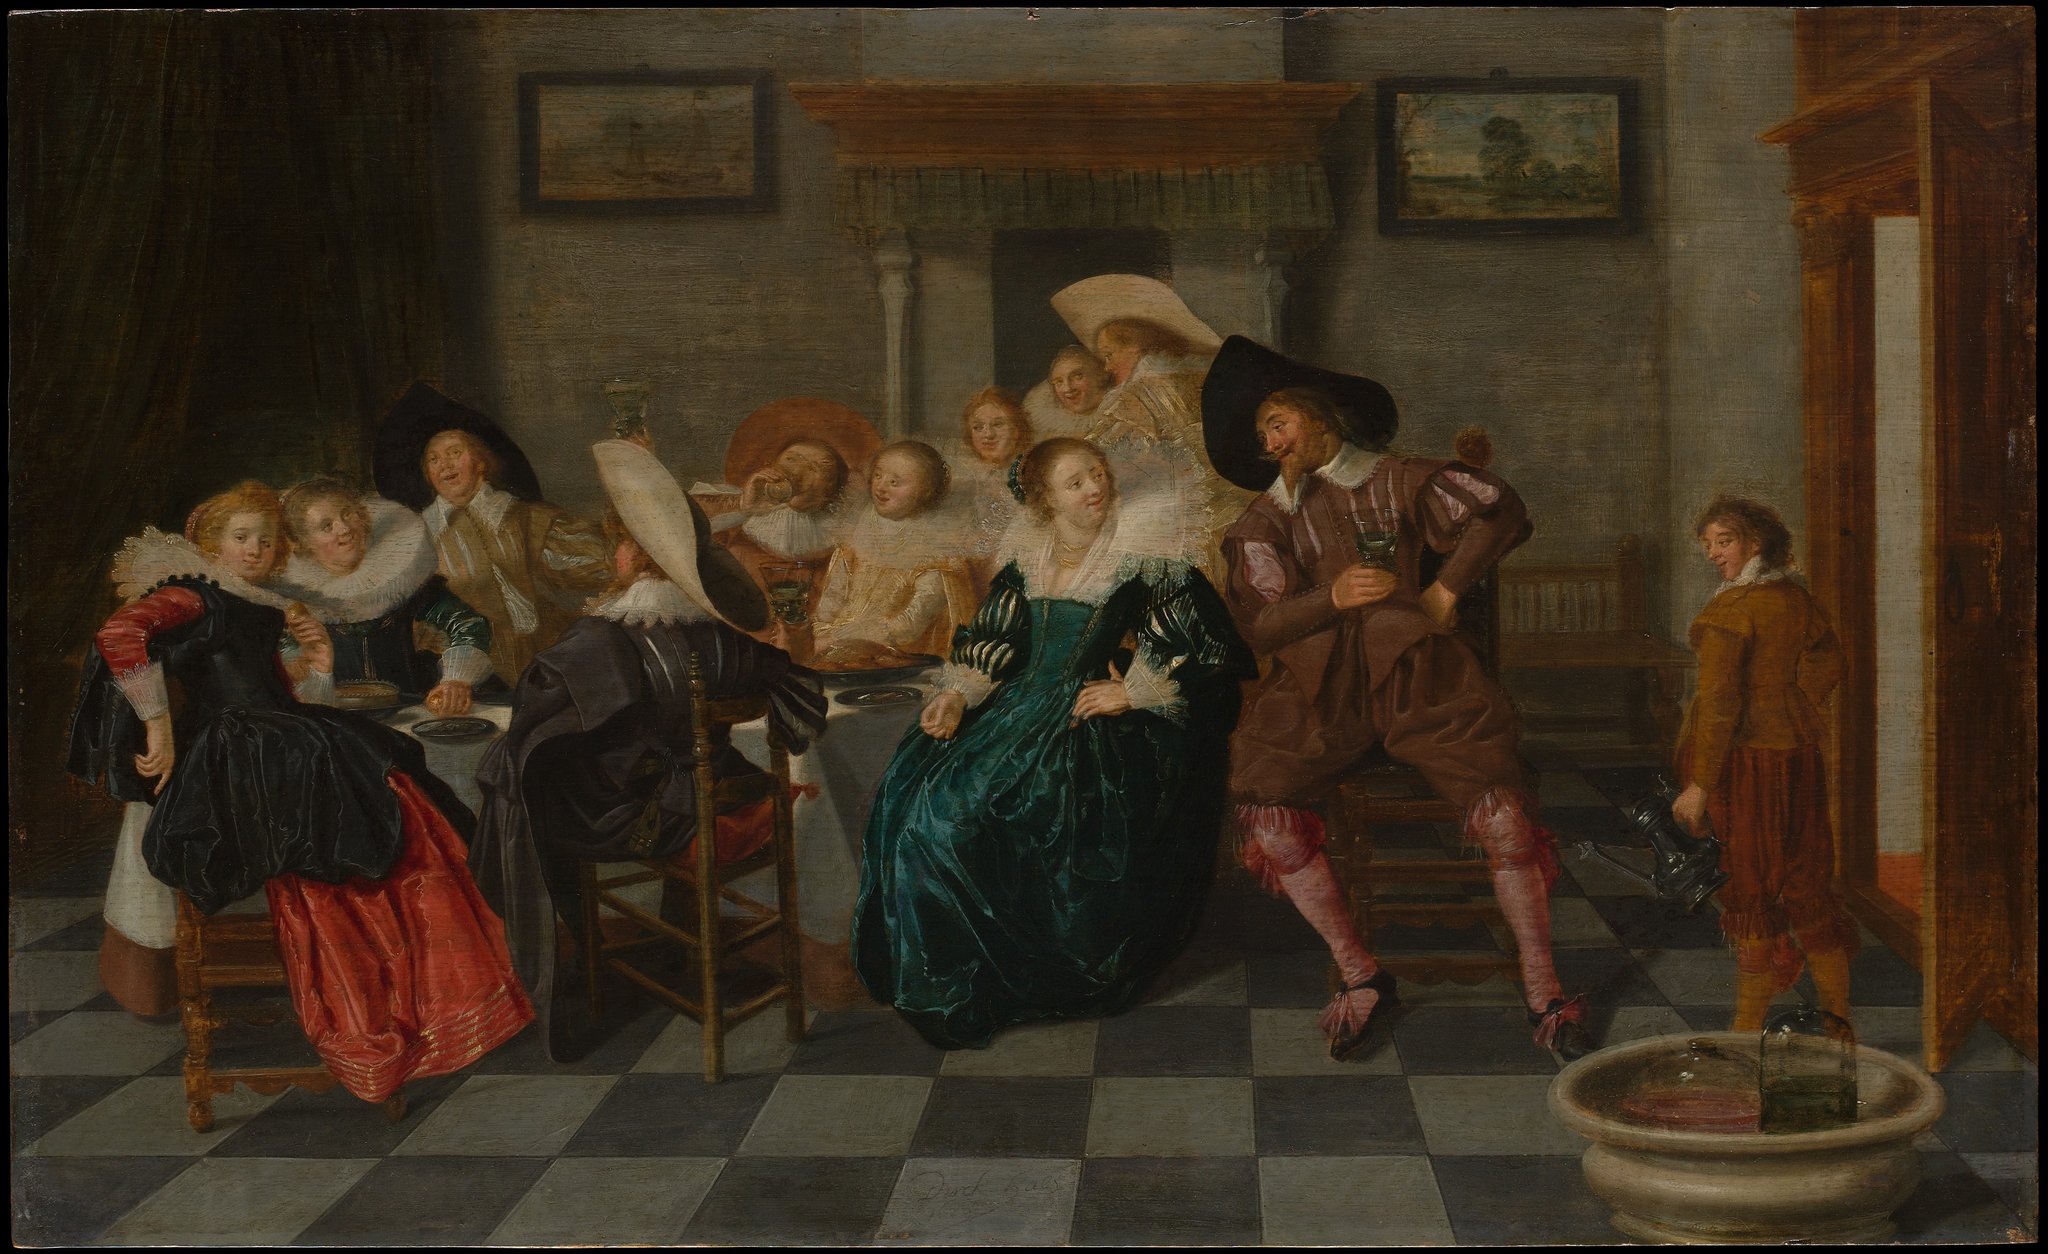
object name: painting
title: A Banquet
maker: dirck hals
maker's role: artist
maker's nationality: dutch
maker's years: 1591-1656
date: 1628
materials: oil, wood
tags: interiors,men,women,dining